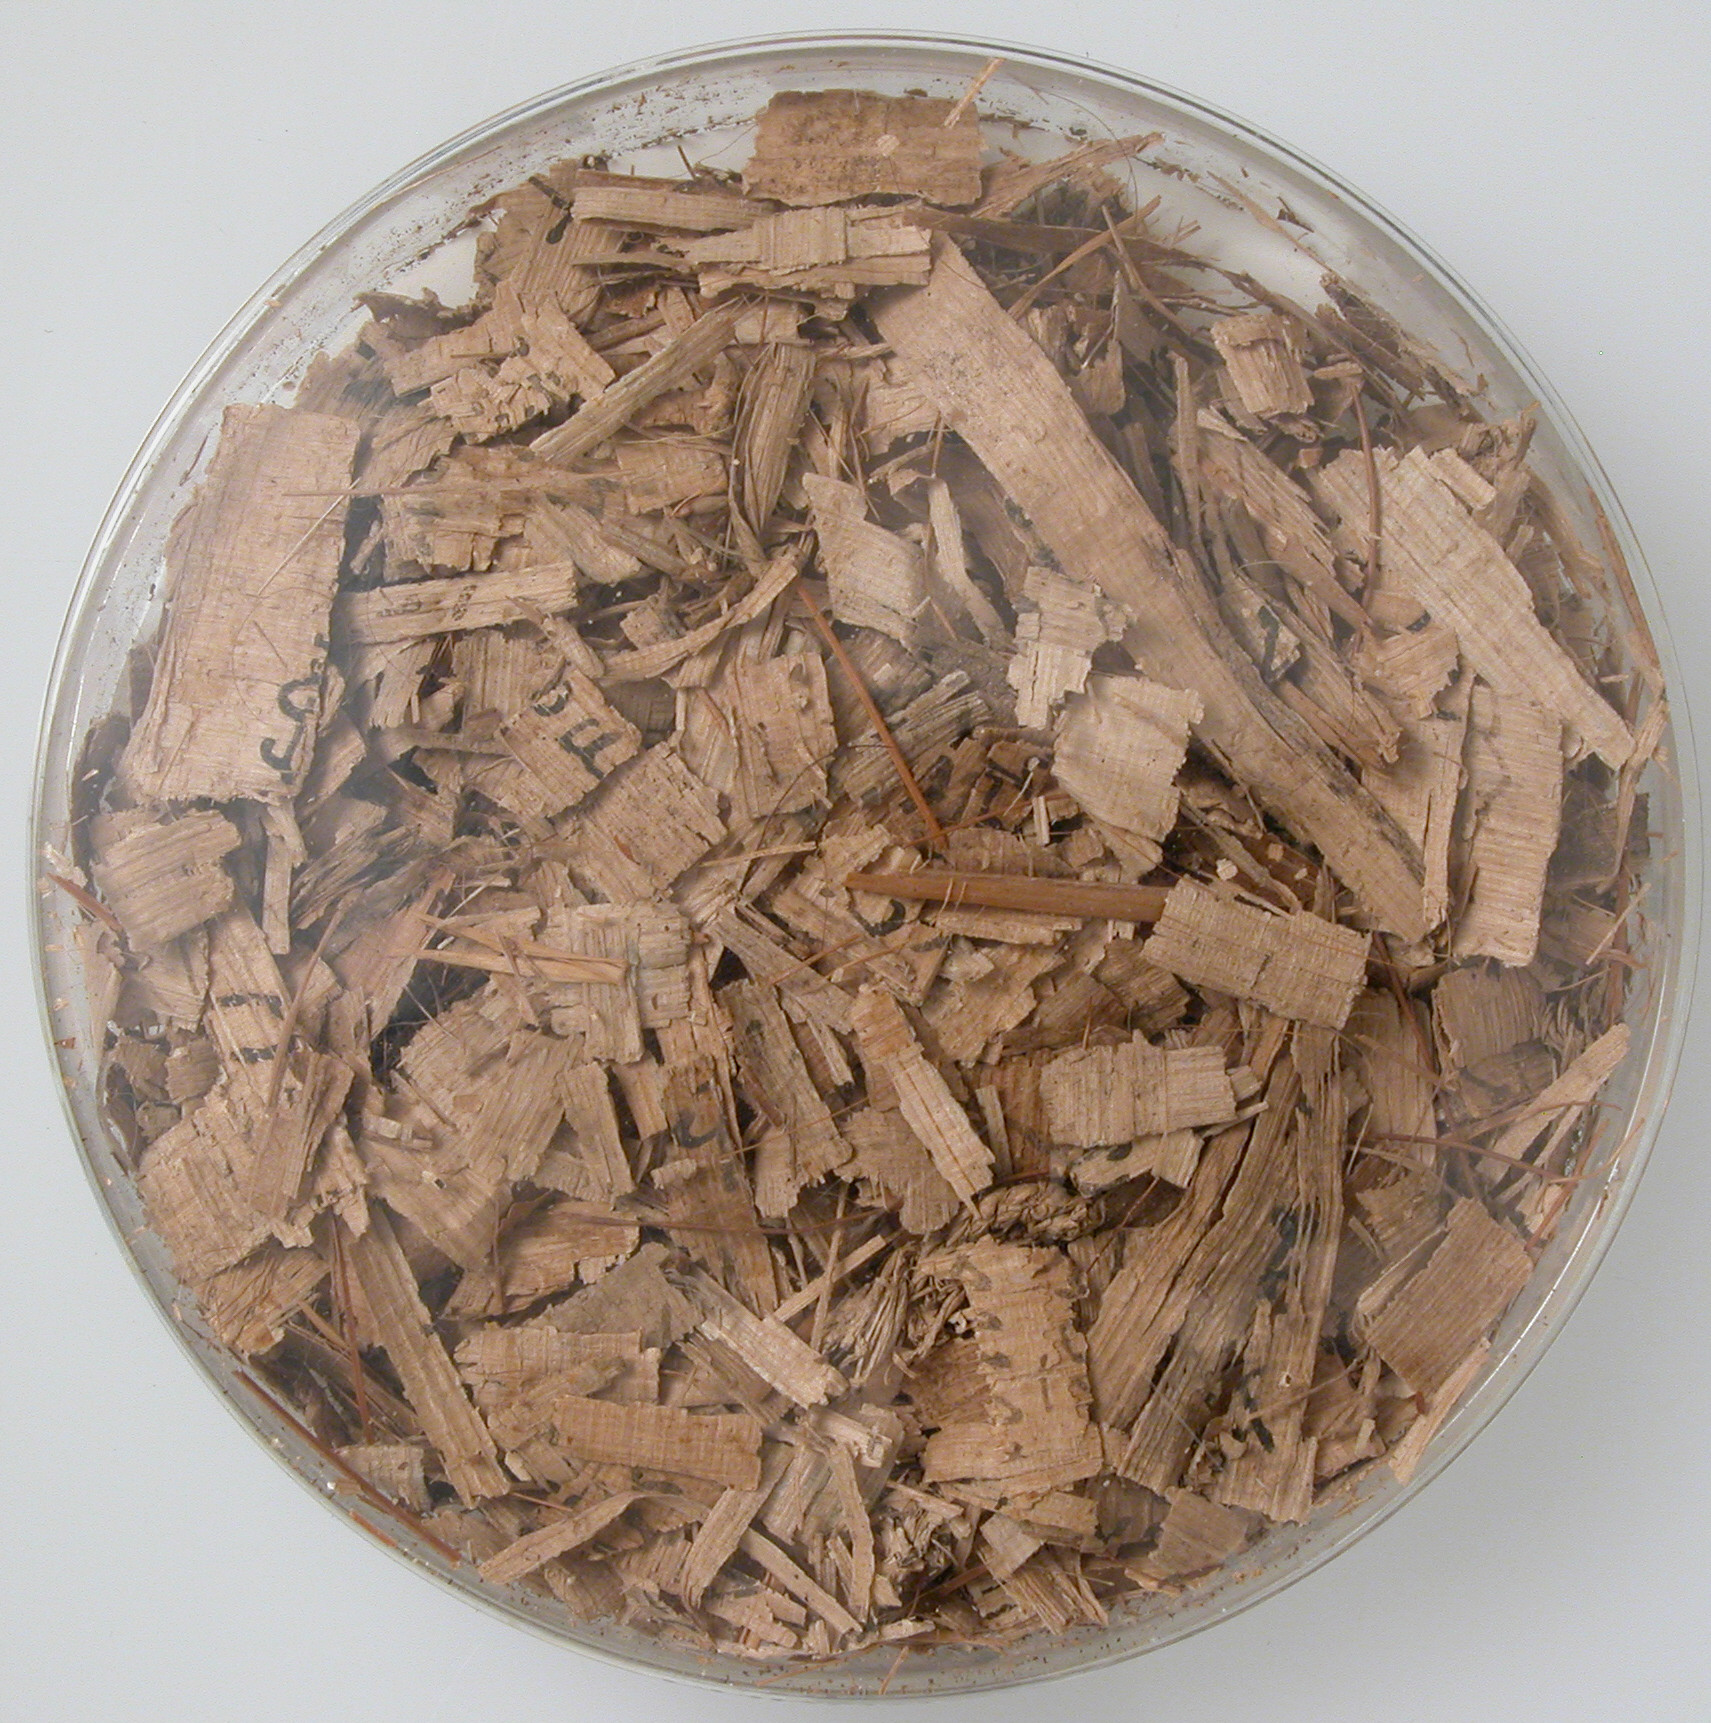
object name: fragment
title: Papyri Fragments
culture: coptic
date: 601-700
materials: ink, papyrus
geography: egypt